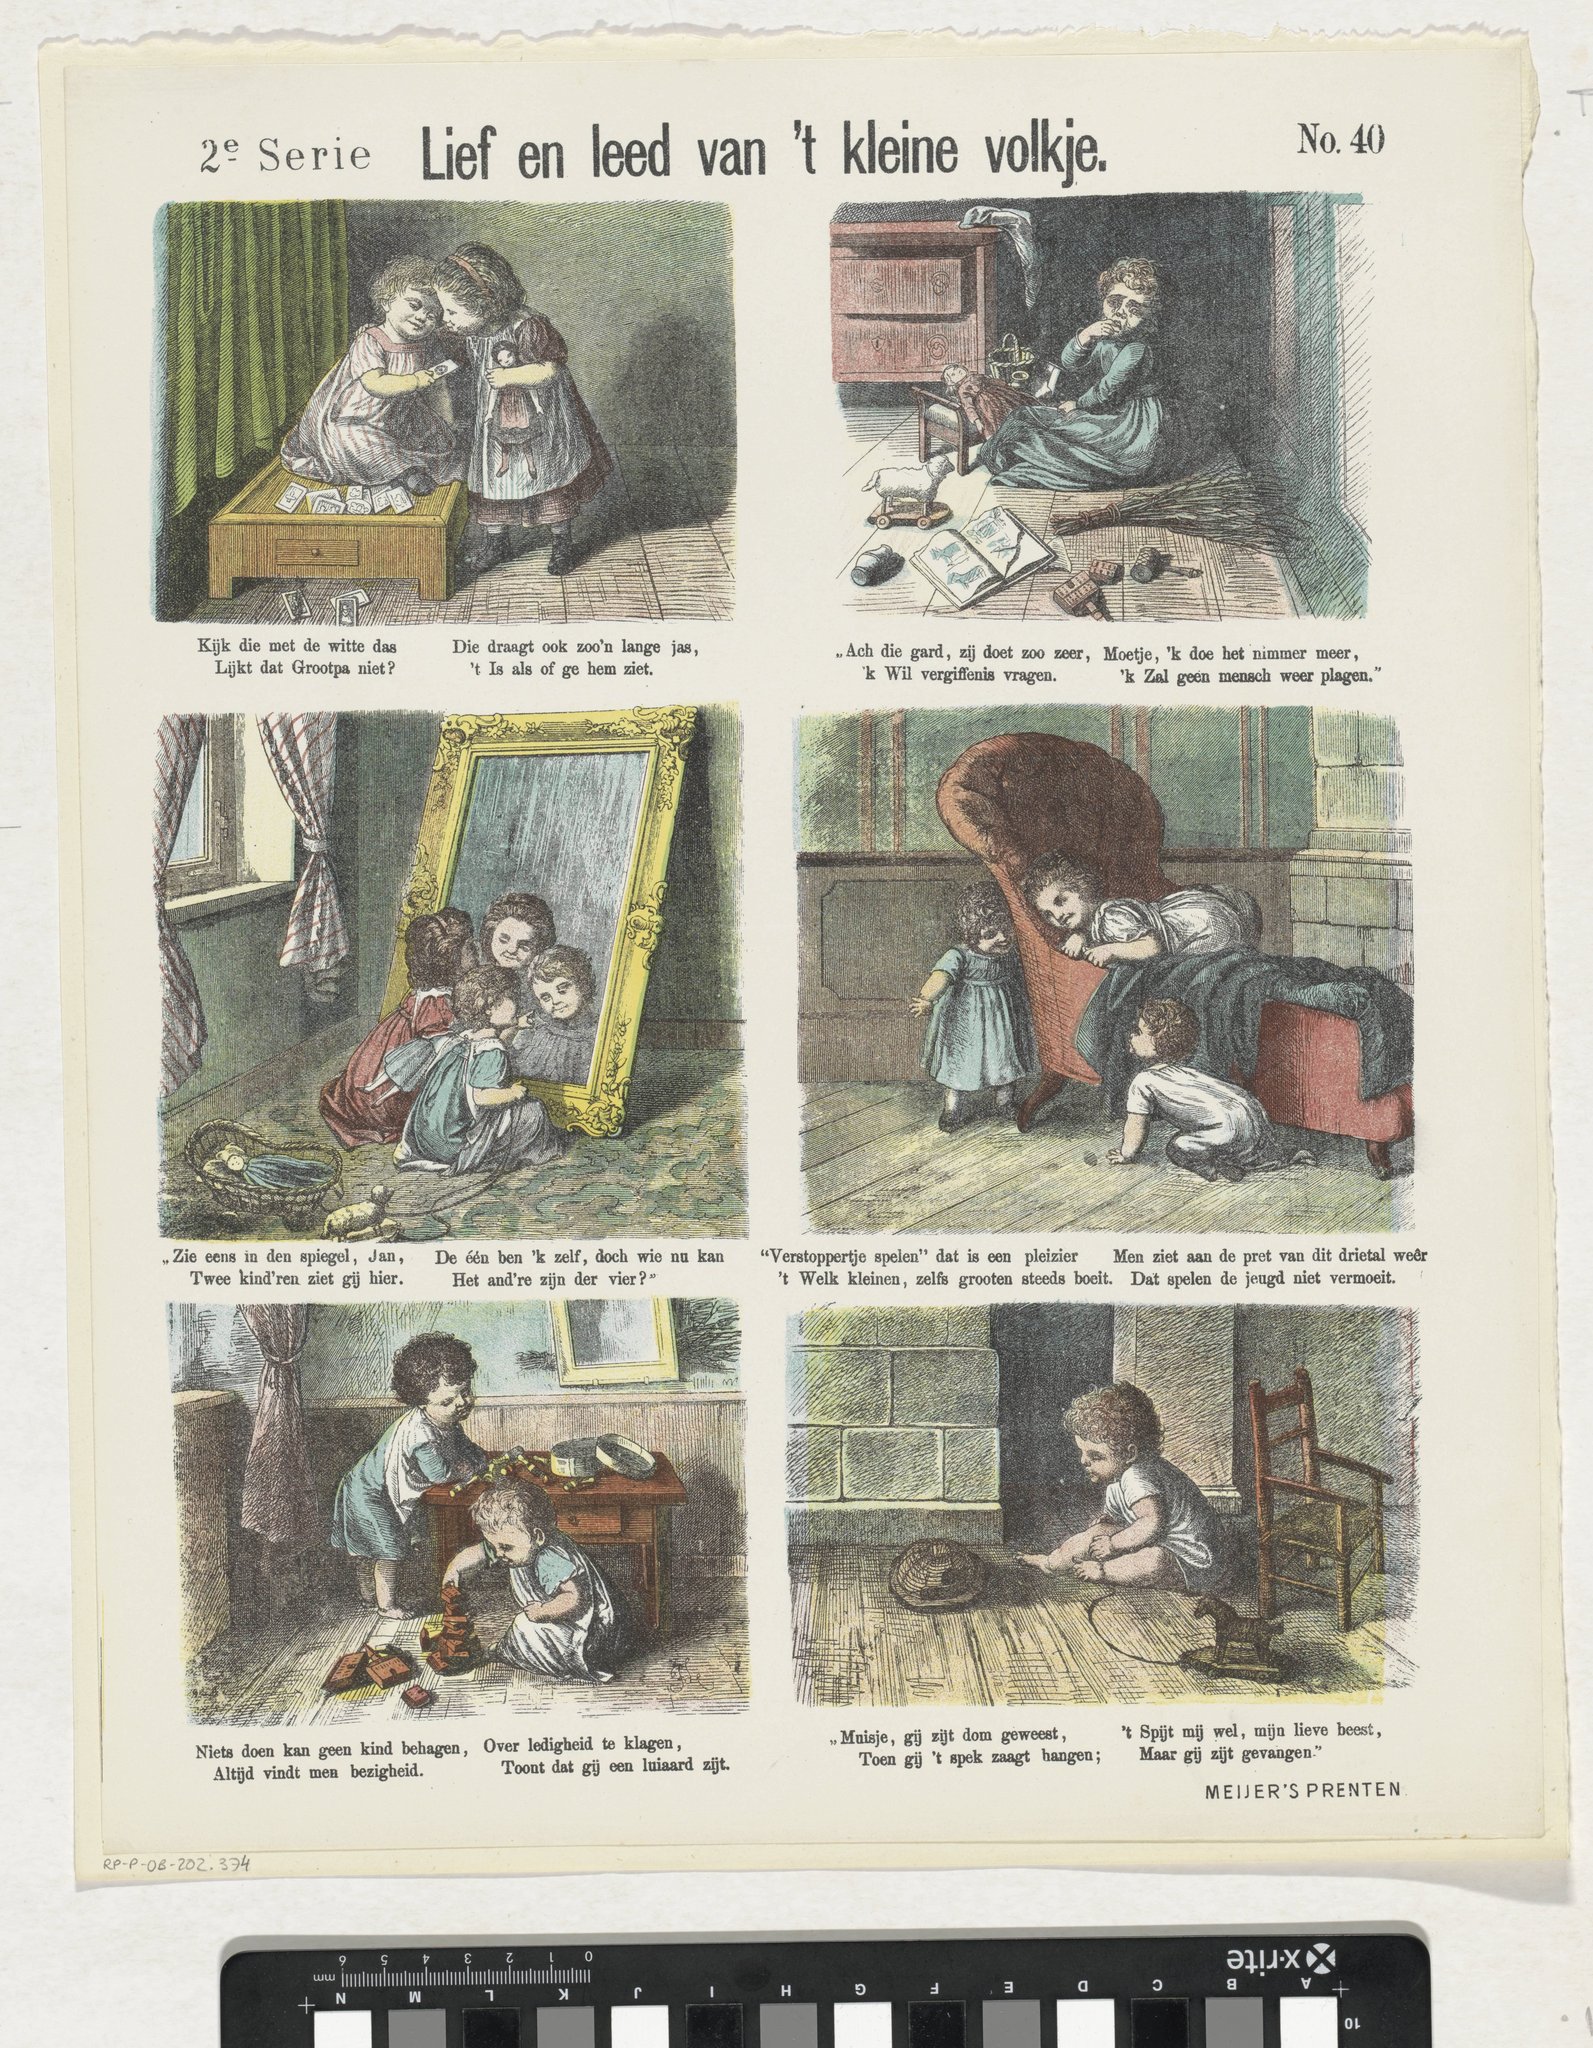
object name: popular print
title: Lief en leed van 't kleine volkje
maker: Anonymous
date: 1874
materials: paper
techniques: lithograph, letterpress printing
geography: amsterdam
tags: correction of naughty children, children's games and plays, bad behaviour, good behaviour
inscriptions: collector's mark: Lugt 2760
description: Blad met 6 voorstellingen van het goede en slechte gedrag van kinderen, waaronder voorstellingen van kinderen die foto's kijken, een pak slaag verdienen, in de spiegel kijken, verstoppertje spelen, een toren bouwen en een muis vangen. Onder elke afbeelding een vierregelig vers in twee kolommen. Genummerd rechtsboven: No. 40.